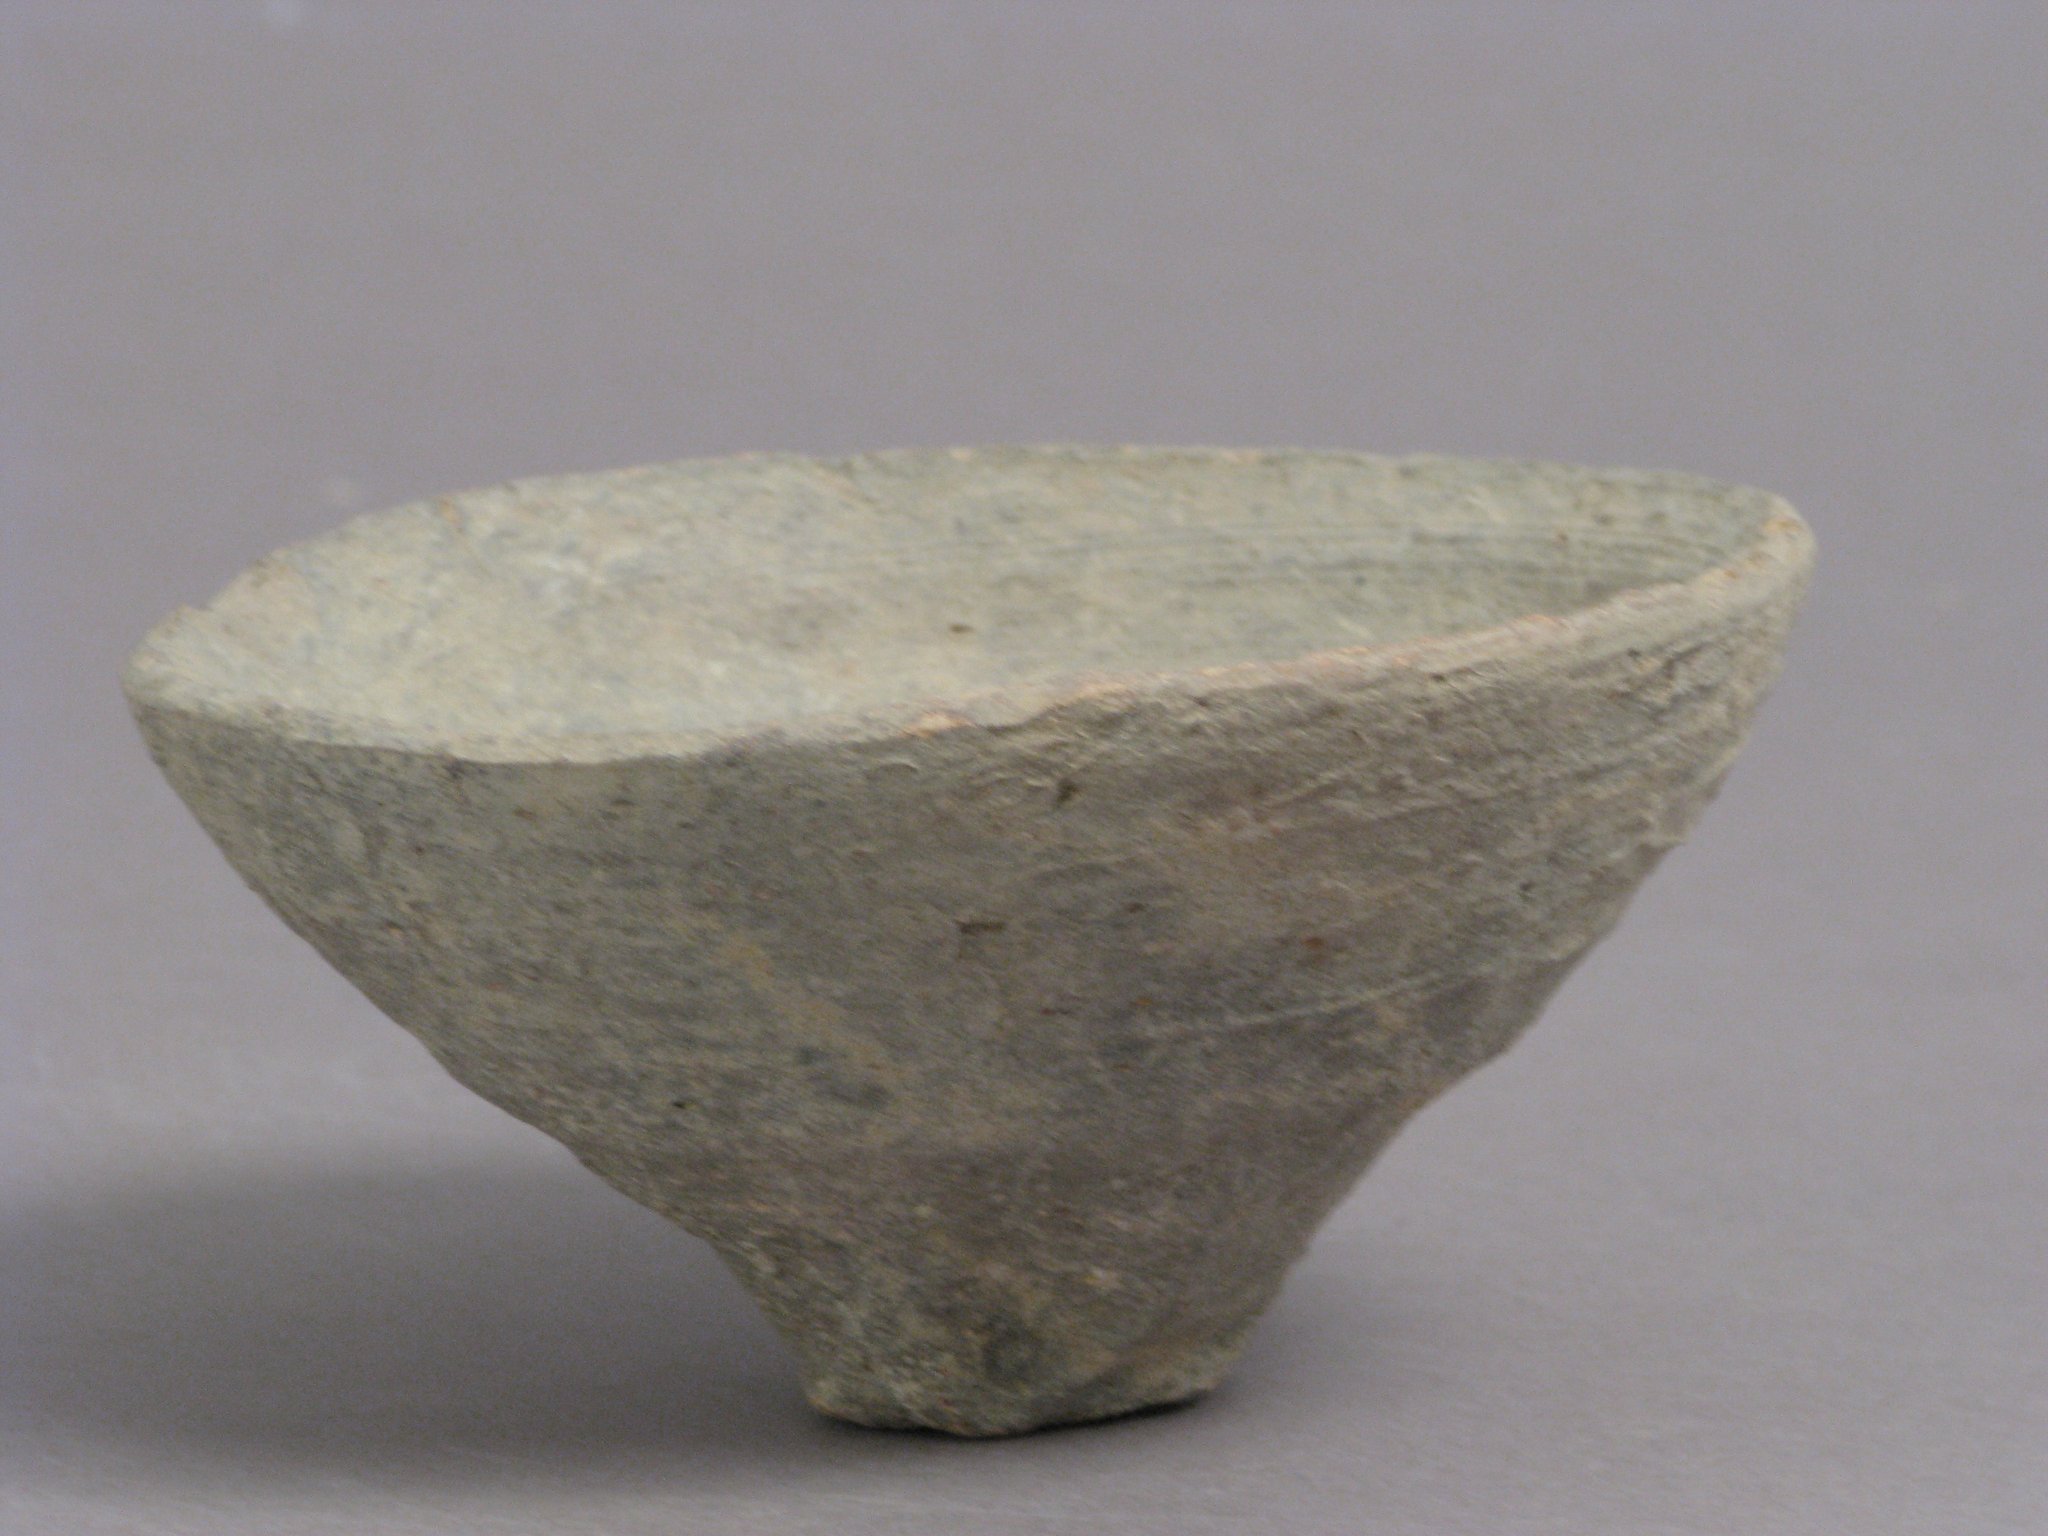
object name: cup or lid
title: Footless Cup or Lid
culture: coptic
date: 301-700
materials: earthenware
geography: egypt